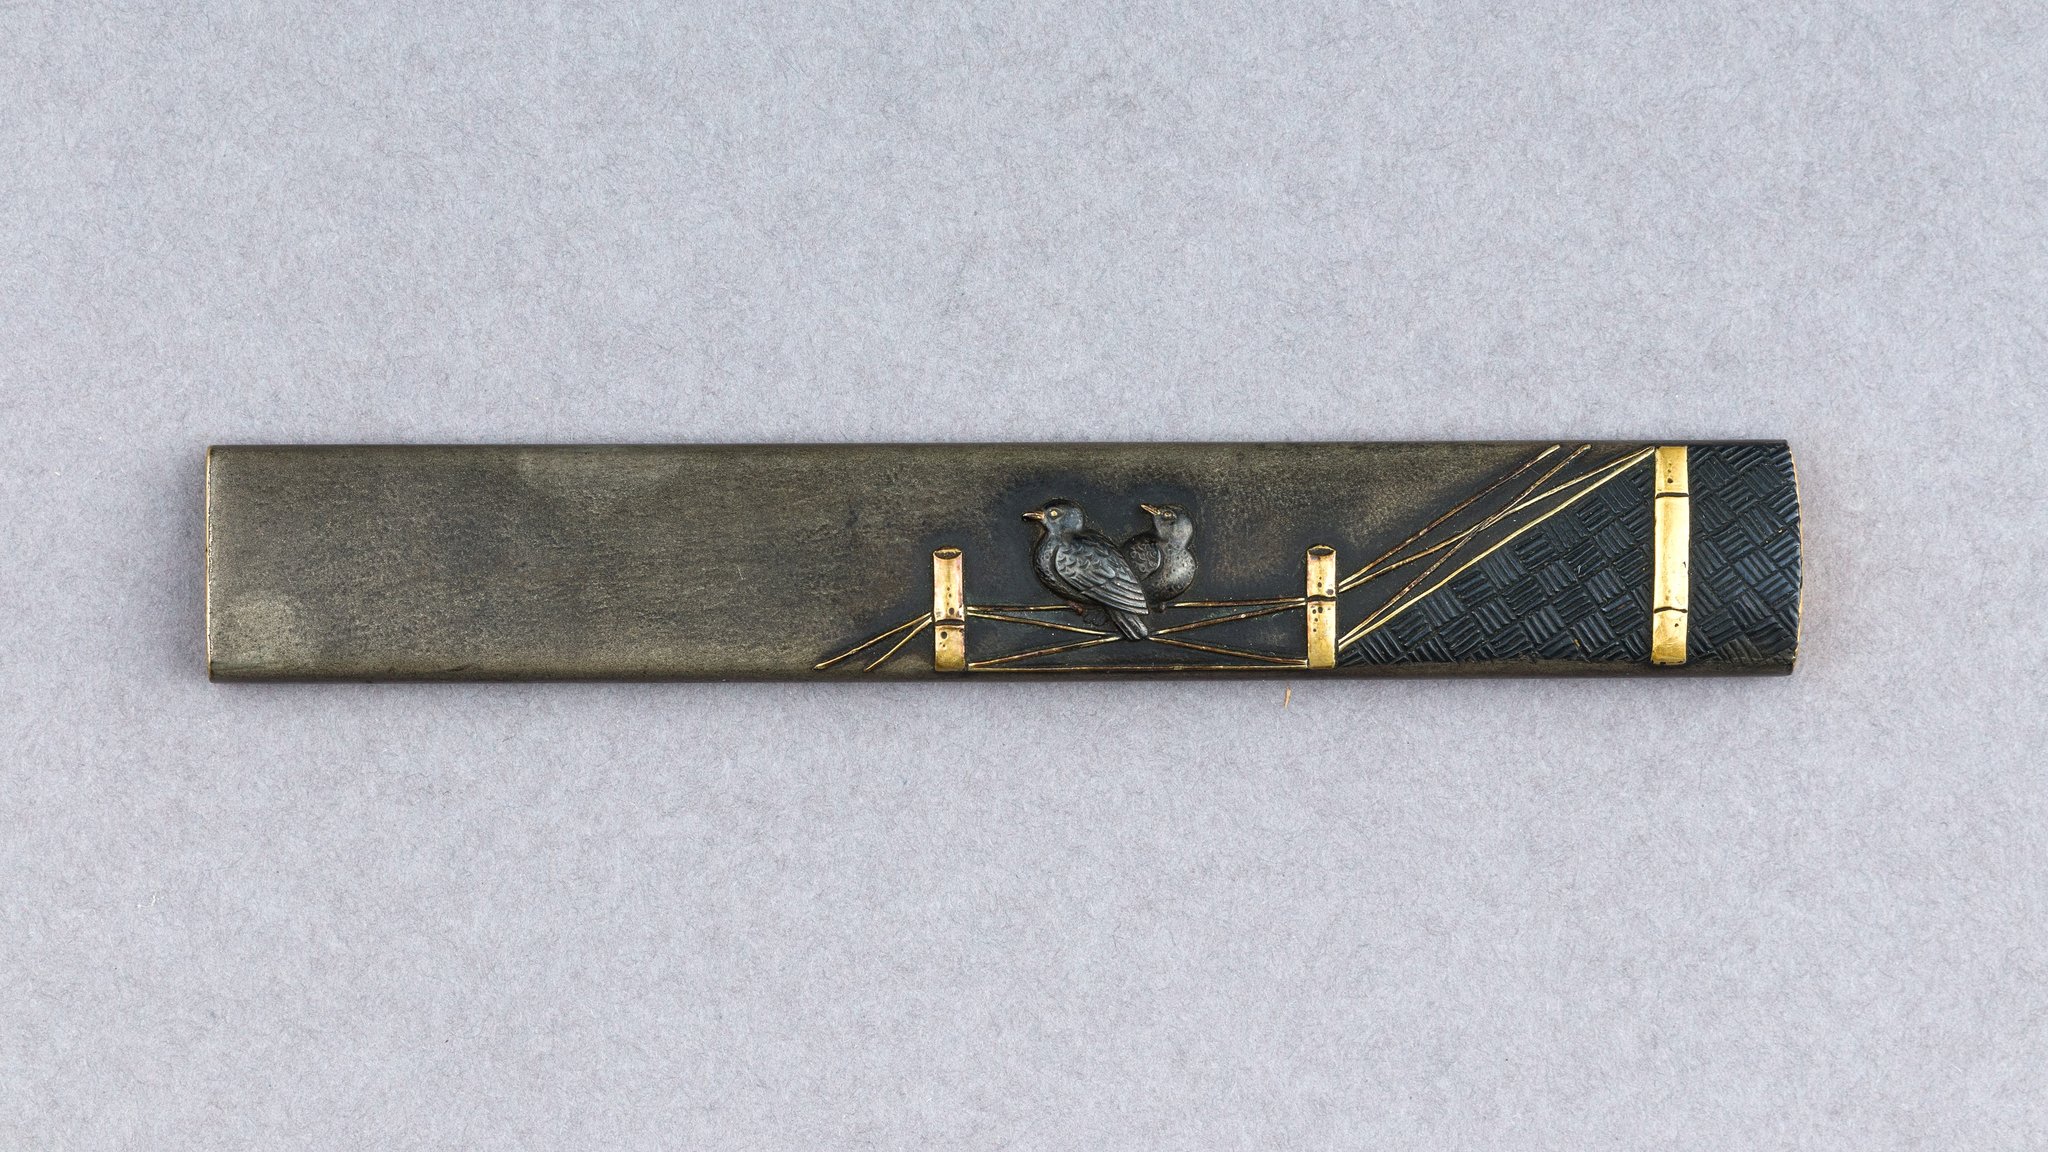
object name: knife handle kozuka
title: Knife Handle (Kozuka)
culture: japanese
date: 1615-1868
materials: gold alloy, silver alloy, gold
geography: japan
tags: birds